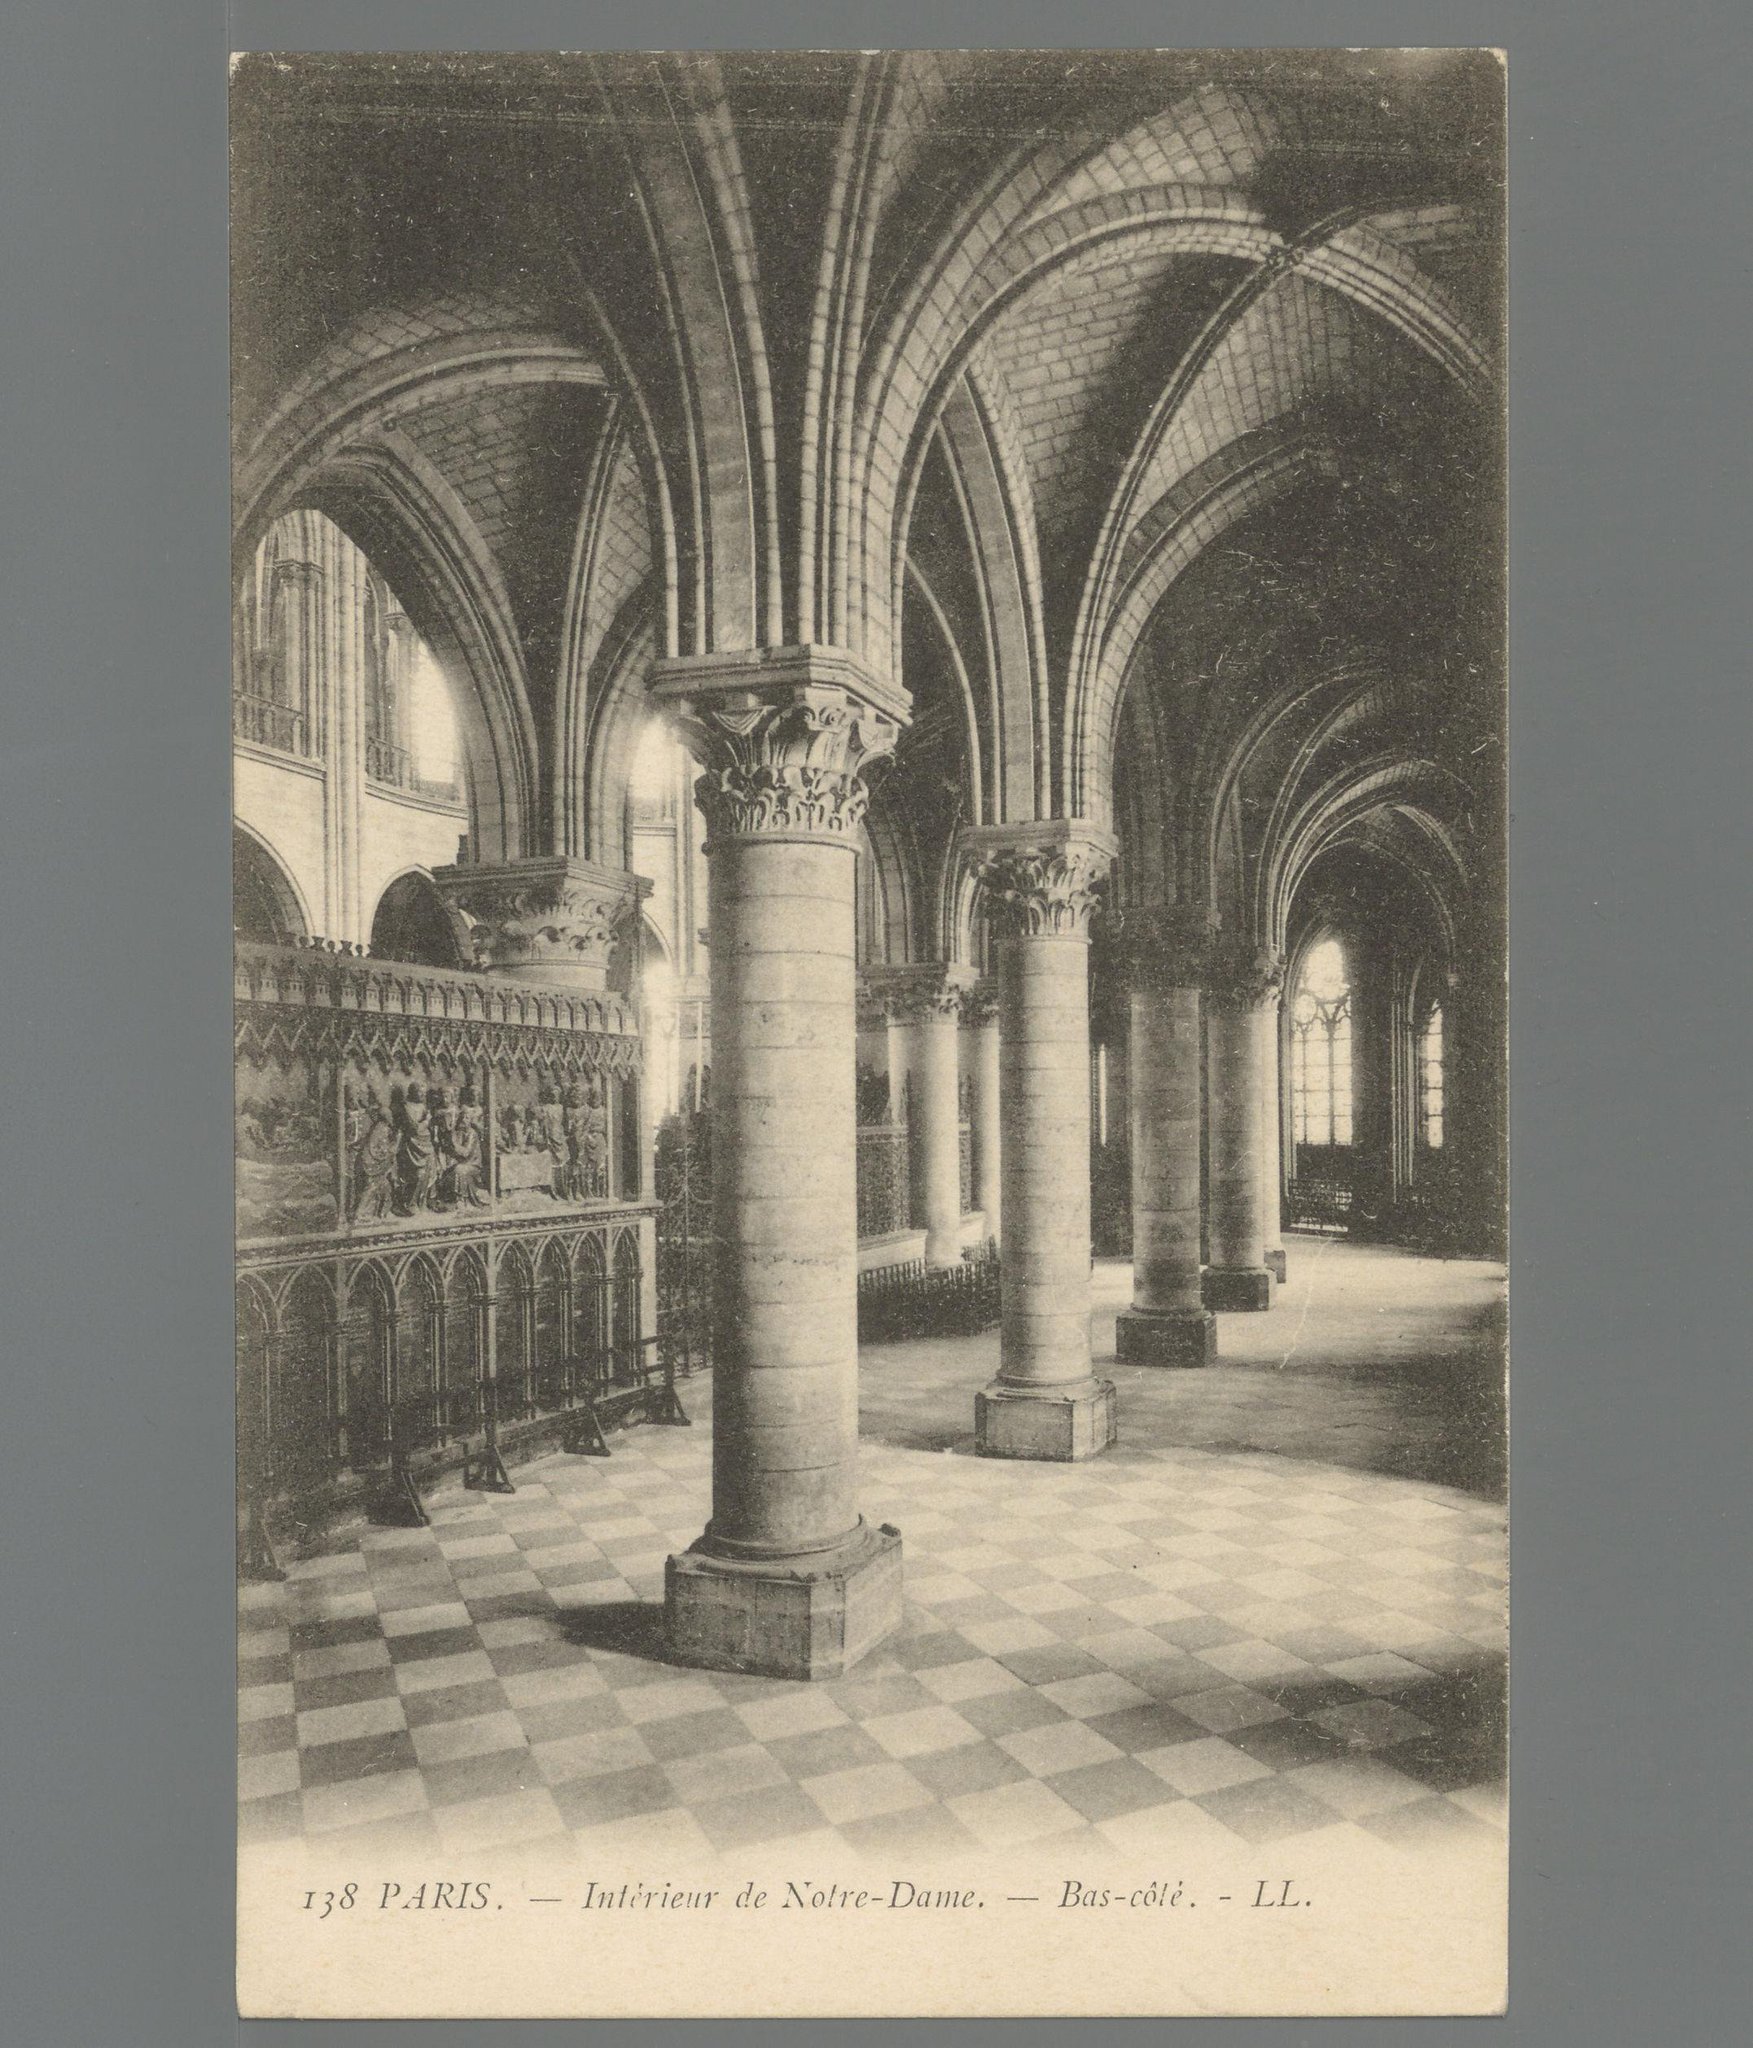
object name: photomechanical print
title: Paris. Intérieur de Notre-Dame. Bas-côté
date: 1895-1904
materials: cardboard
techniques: photograph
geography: paris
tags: column, pillar ~ architecture, interior of church